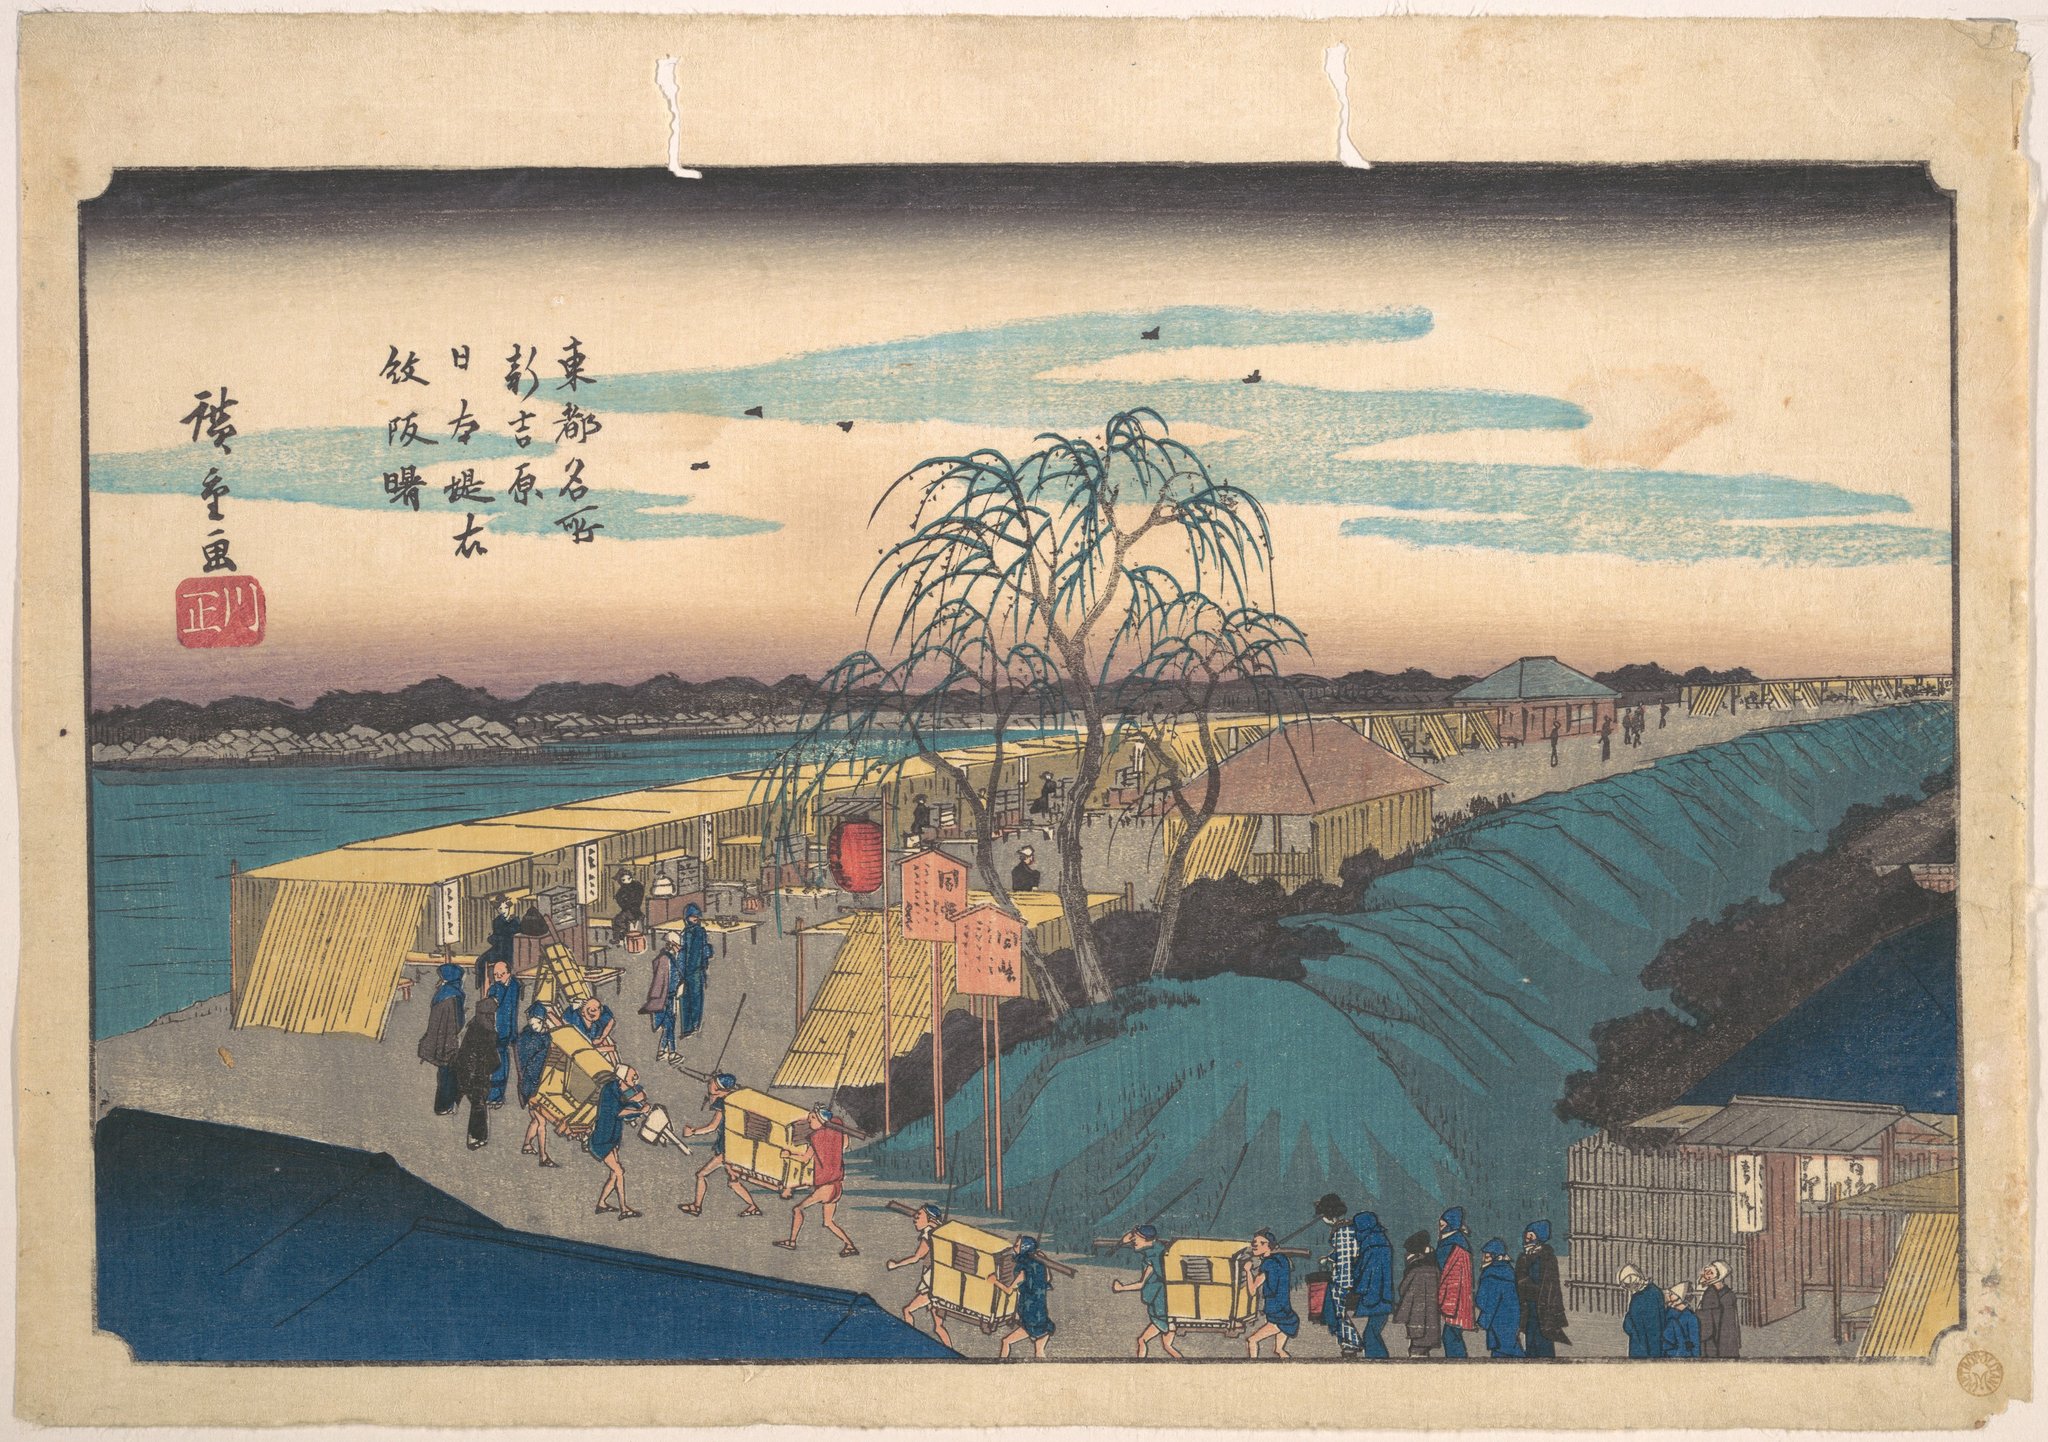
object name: print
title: Shin Yoshiwara Nihon Tsutsumi Emonzaka Akatsuki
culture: japanese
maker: utagawa hiroshige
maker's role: artist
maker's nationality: japanese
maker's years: 1797-1858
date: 1835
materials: ink, paper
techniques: woodblock print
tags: human figures,street scene